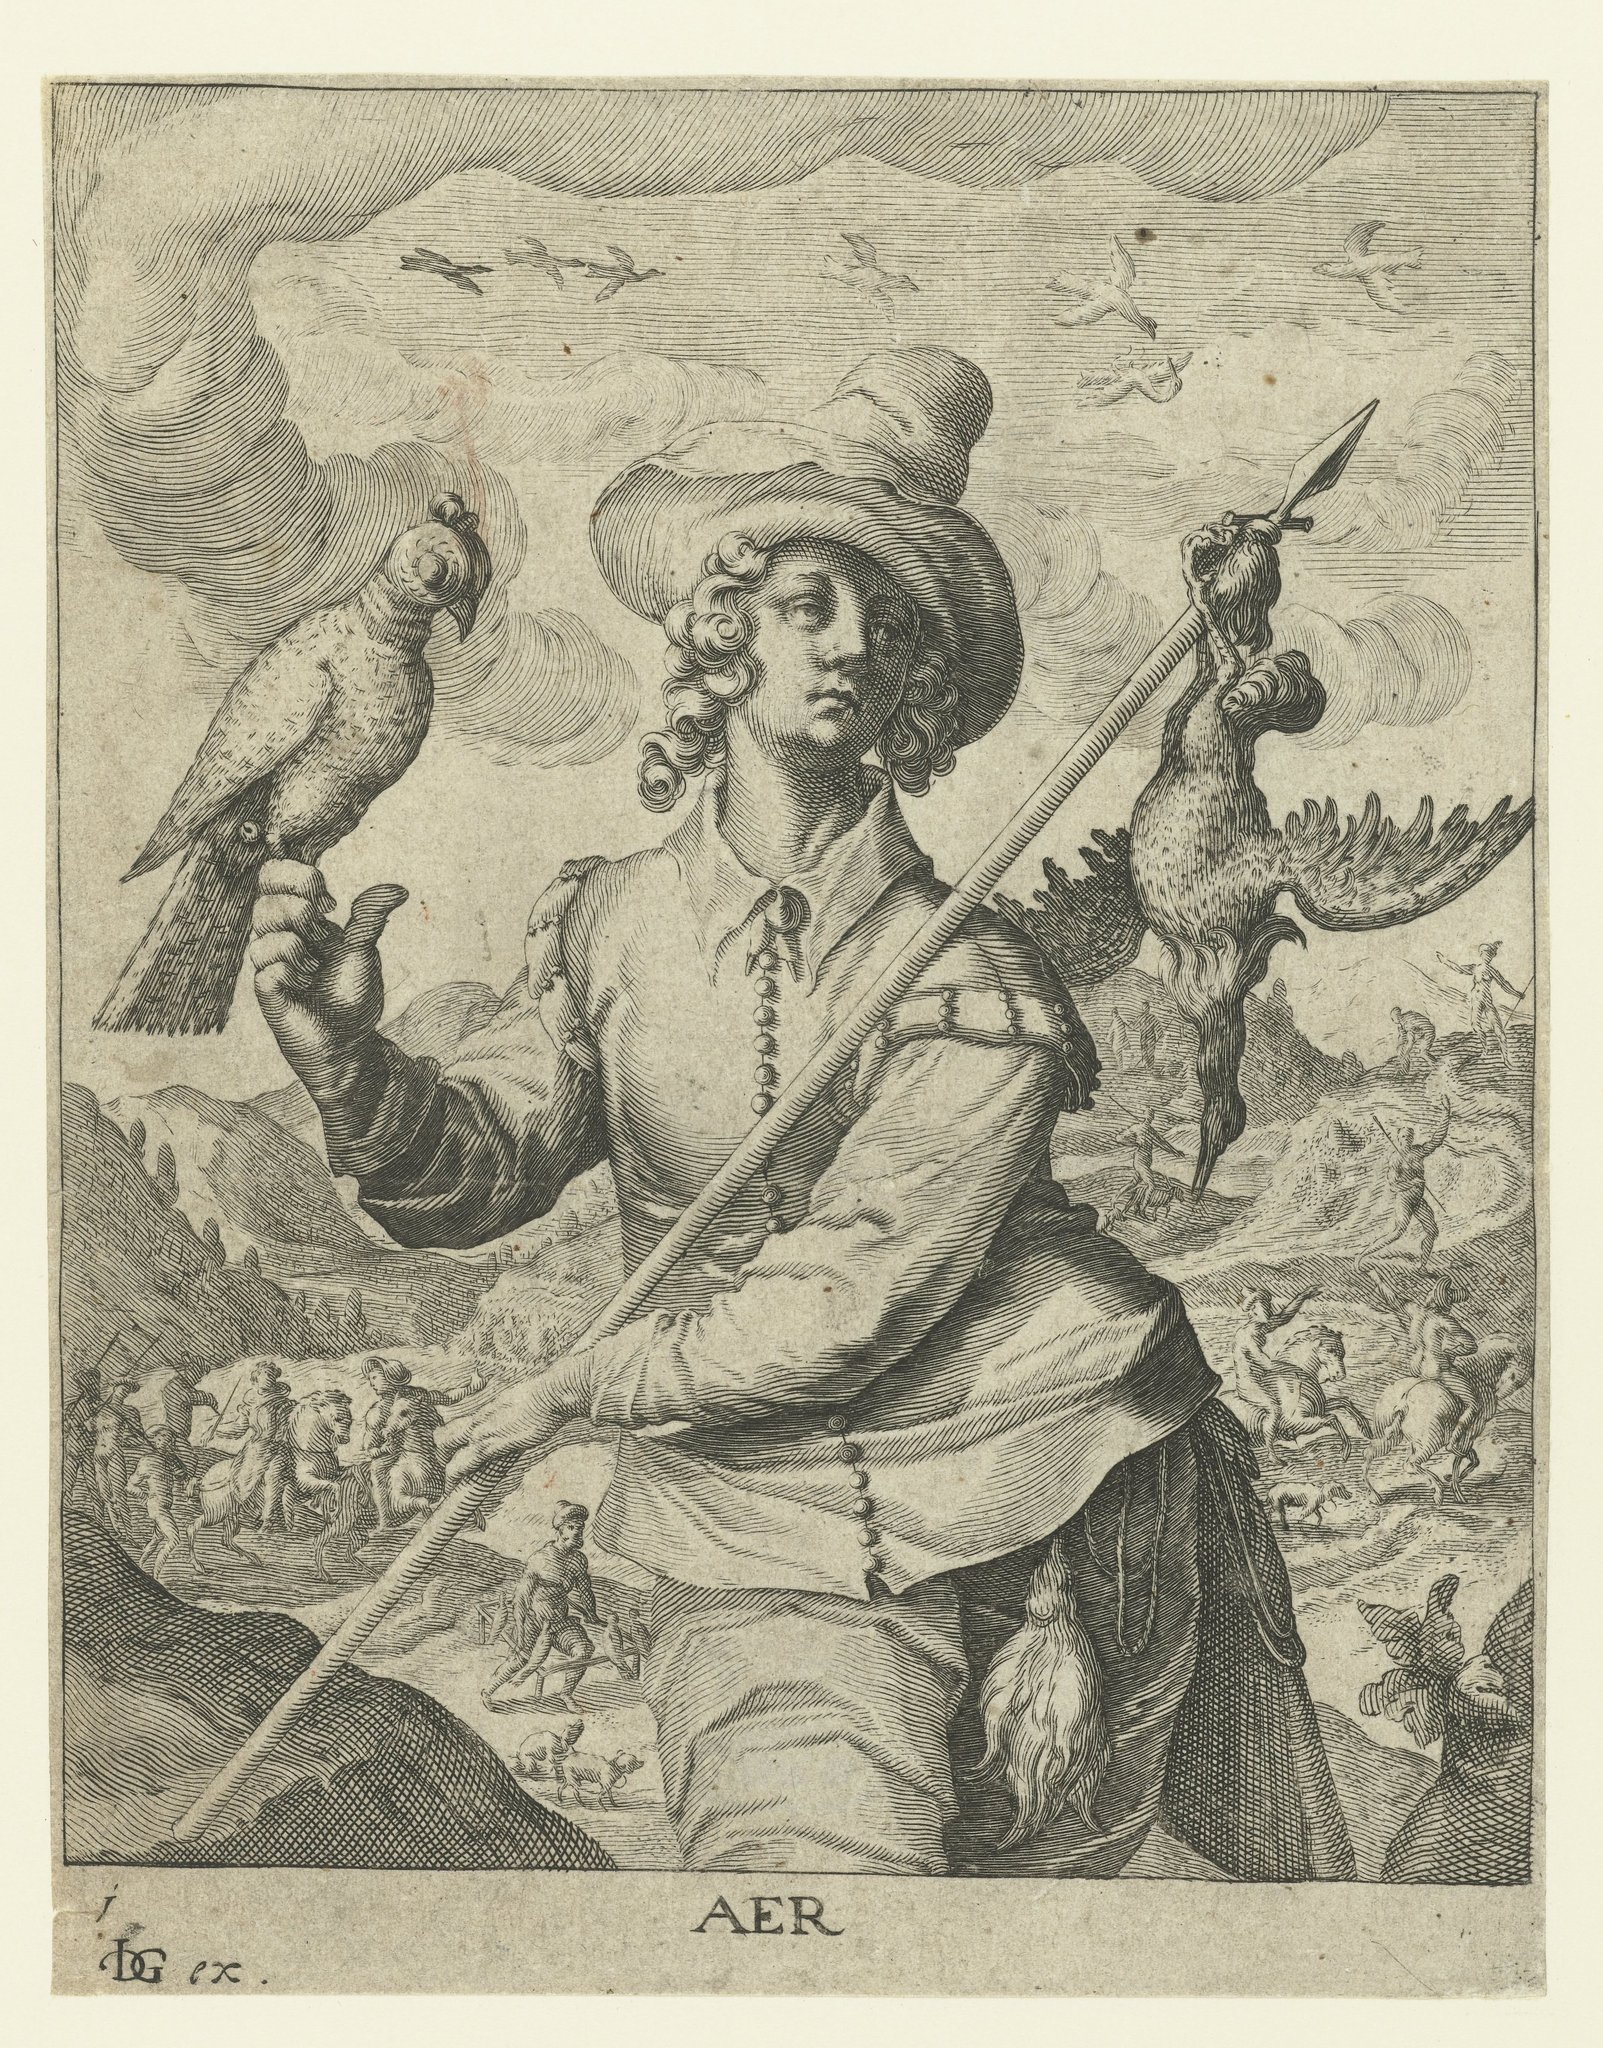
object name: print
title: De vier elementen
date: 1595-1597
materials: paper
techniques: engraving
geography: leiden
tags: air (one of the four elements), sports, games ~ animals (+ hunting with falcon, hawk; falconry)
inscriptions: collector's mark: Lugt 2228a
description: Voorstelling van het element lucht in de vorm van een jonge valkenier met een valk op de arm en een lans met een dode vogel eraan over de schouder. Op de achtergrond een groep jagers met valken in een heuvelachtig landschap. Onder de voorstelling de Latijnse benaming van het element ('AER'). Deze prent is onderdeel van een serie van de vier elementen, elk verbeeld door een figuur verwikkeld in een handeling en zittend/staand in een omgeving die geassocieerd wordt met het betreffende element. Elke voorstelling heeft als onderschrift de Latijnse benaming van het betreffende element.